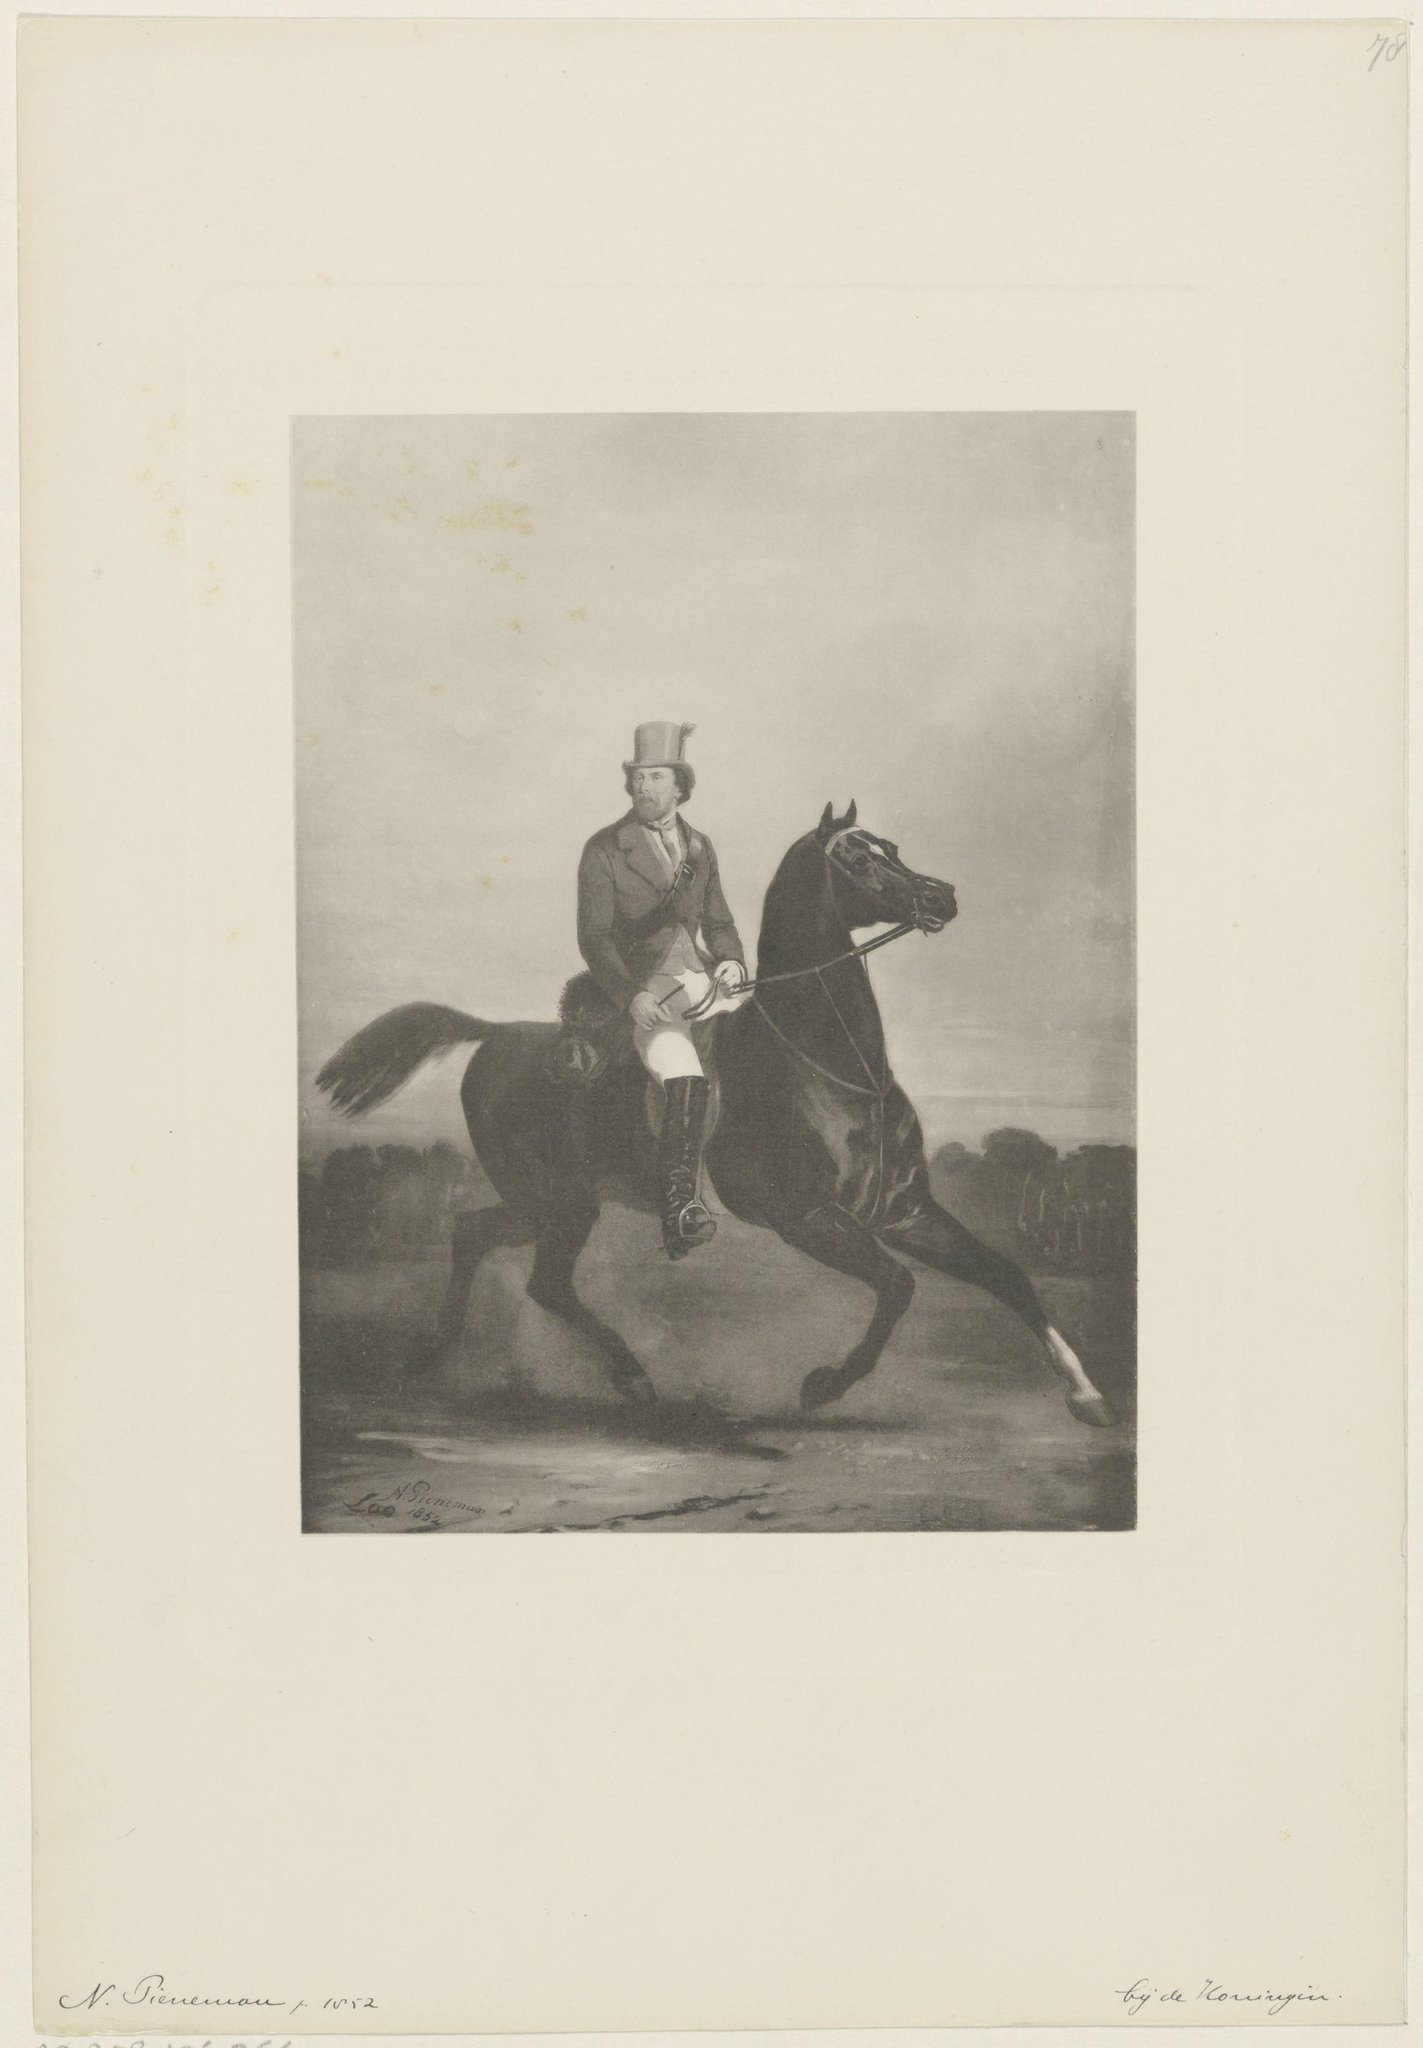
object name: photomechanical print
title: Ruiterportret van Willem III, koning der Nederlanden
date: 1850-1949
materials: paper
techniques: photograph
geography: netherlands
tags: willem iii (koning der nederlanden)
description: De hier vermelde titel verwijst naar de hoogst verkregen titel van de geportretteerde, niet per se naar de titel die de geportretteerde op deze voorstelling draagt.